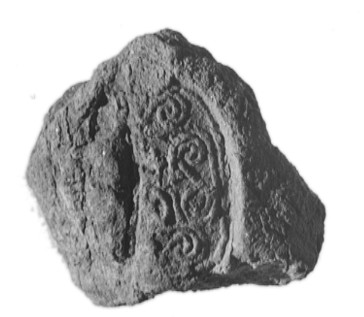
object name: sealing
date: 2030-1640 BCE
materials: clay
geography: egypt